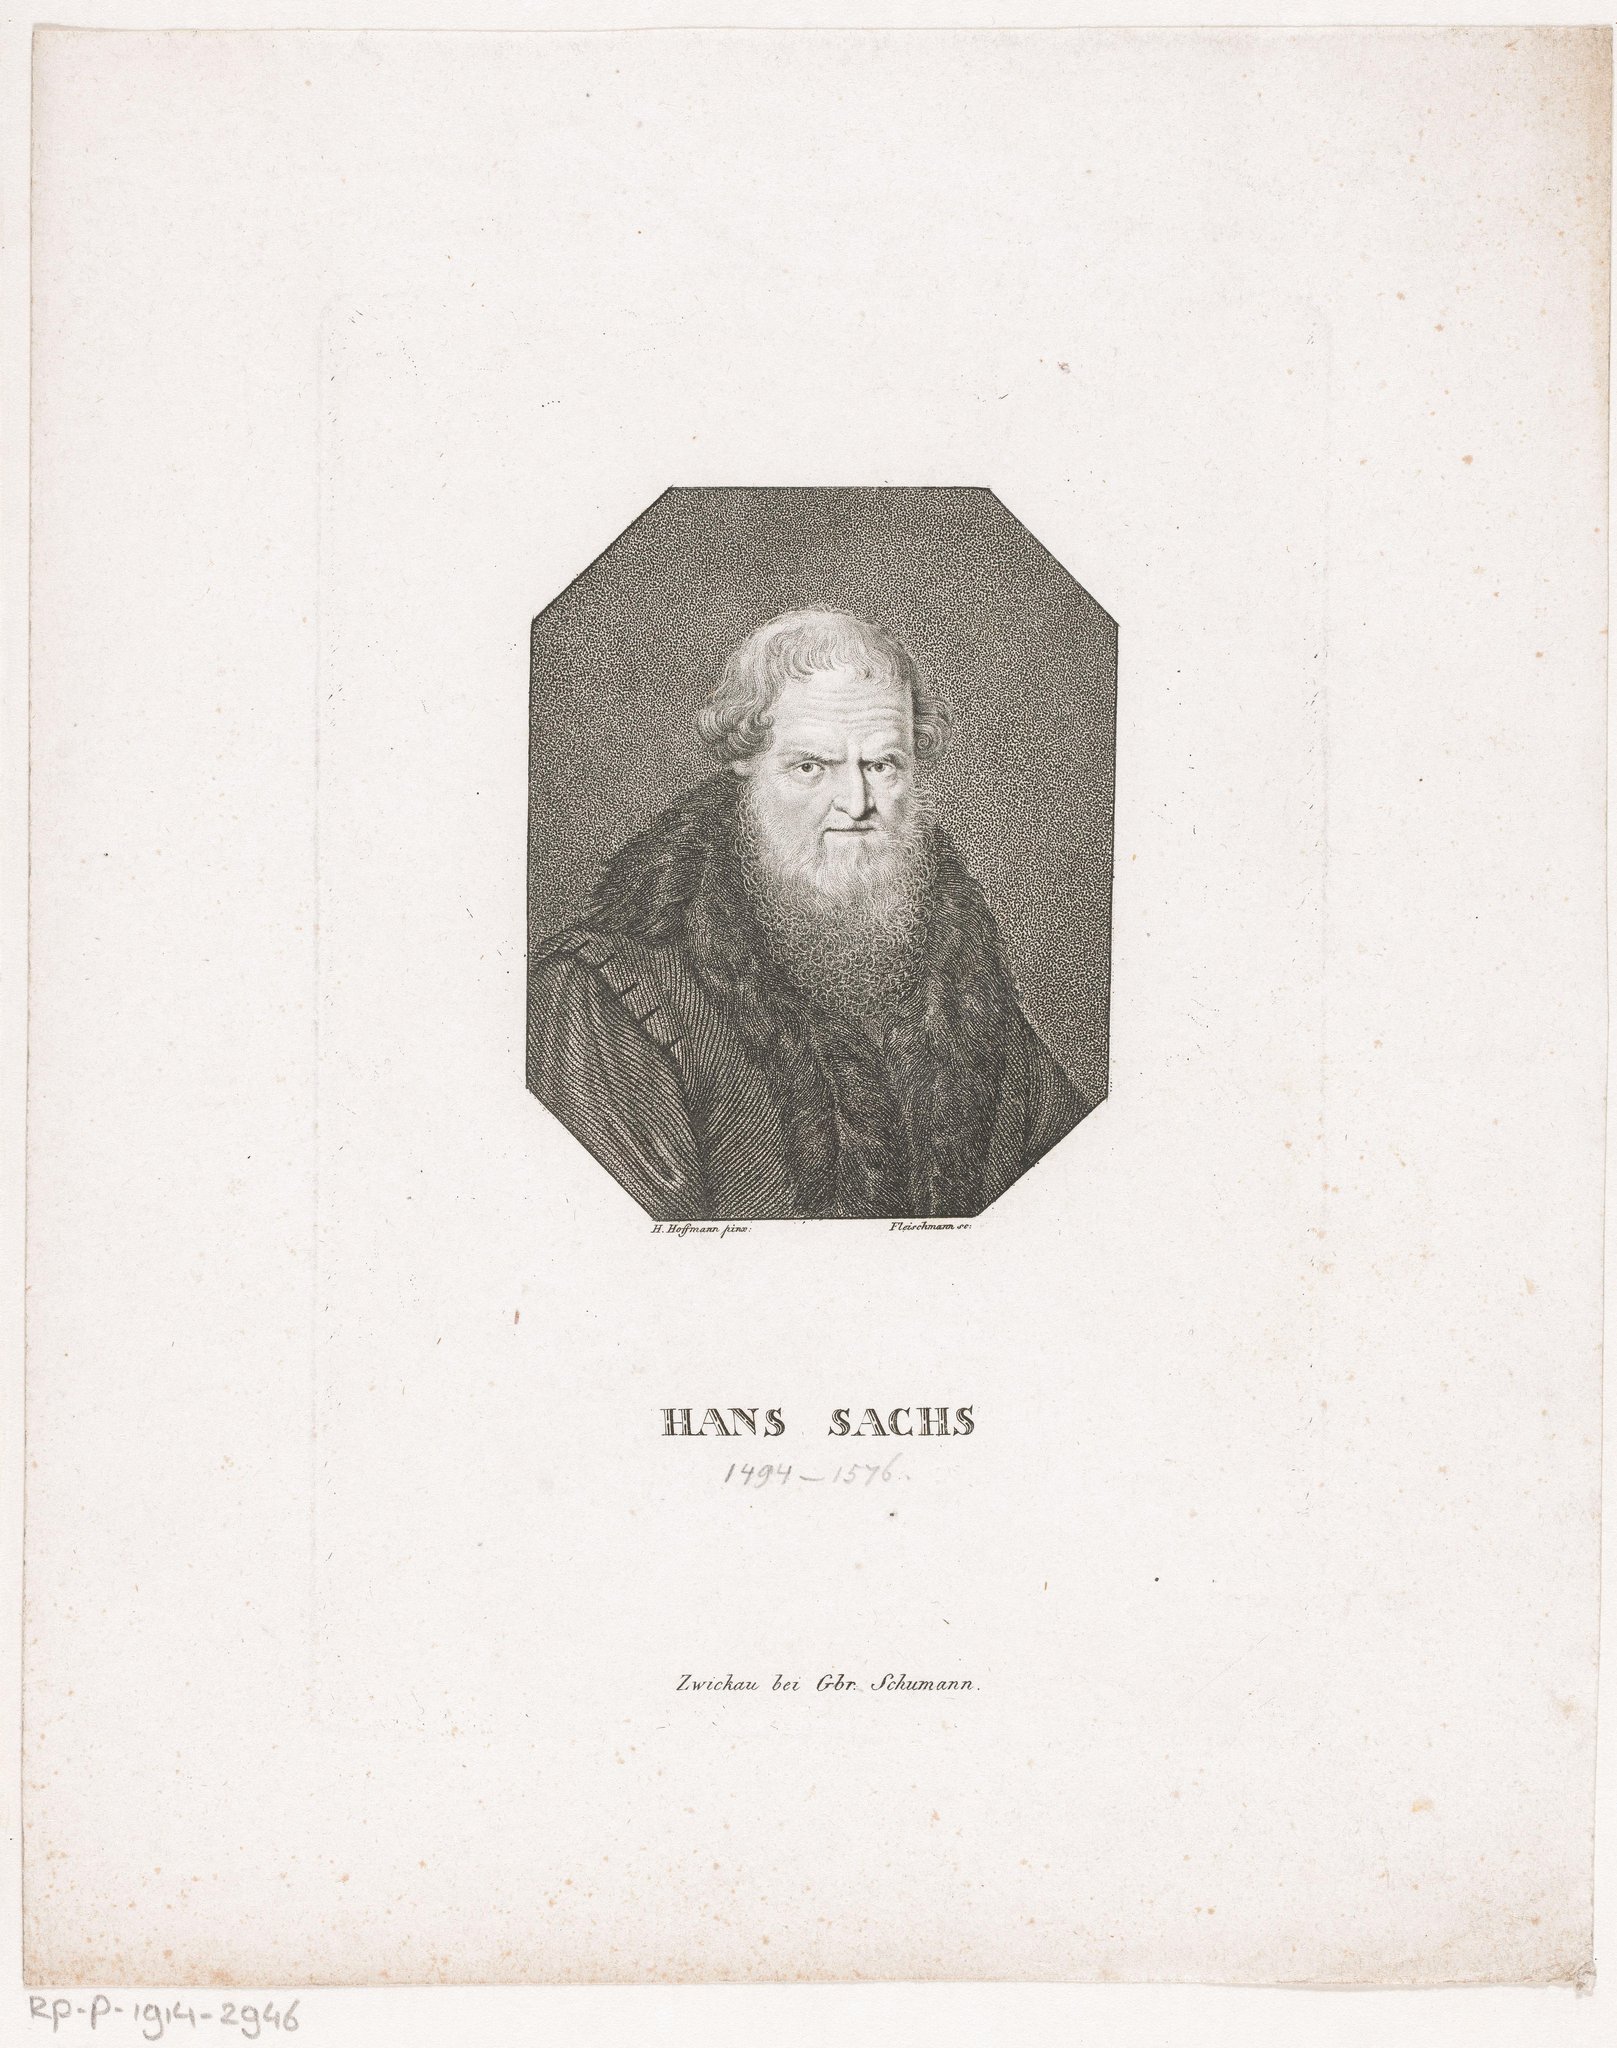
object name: print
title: Portret van Hans Sachs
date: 1818-1832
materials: paper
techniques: engraving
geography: zwickau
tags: hans sachs, historical persons, writer, poet, author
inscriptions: collector's mark: Lugt 2228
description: Prent afkomstig uit: 'Bildnisse der berühmtesten Menschen aller Völker und Zeiten' van de gebroeders Schumann, uitgegeven in 1818-1832 te Zwickau.